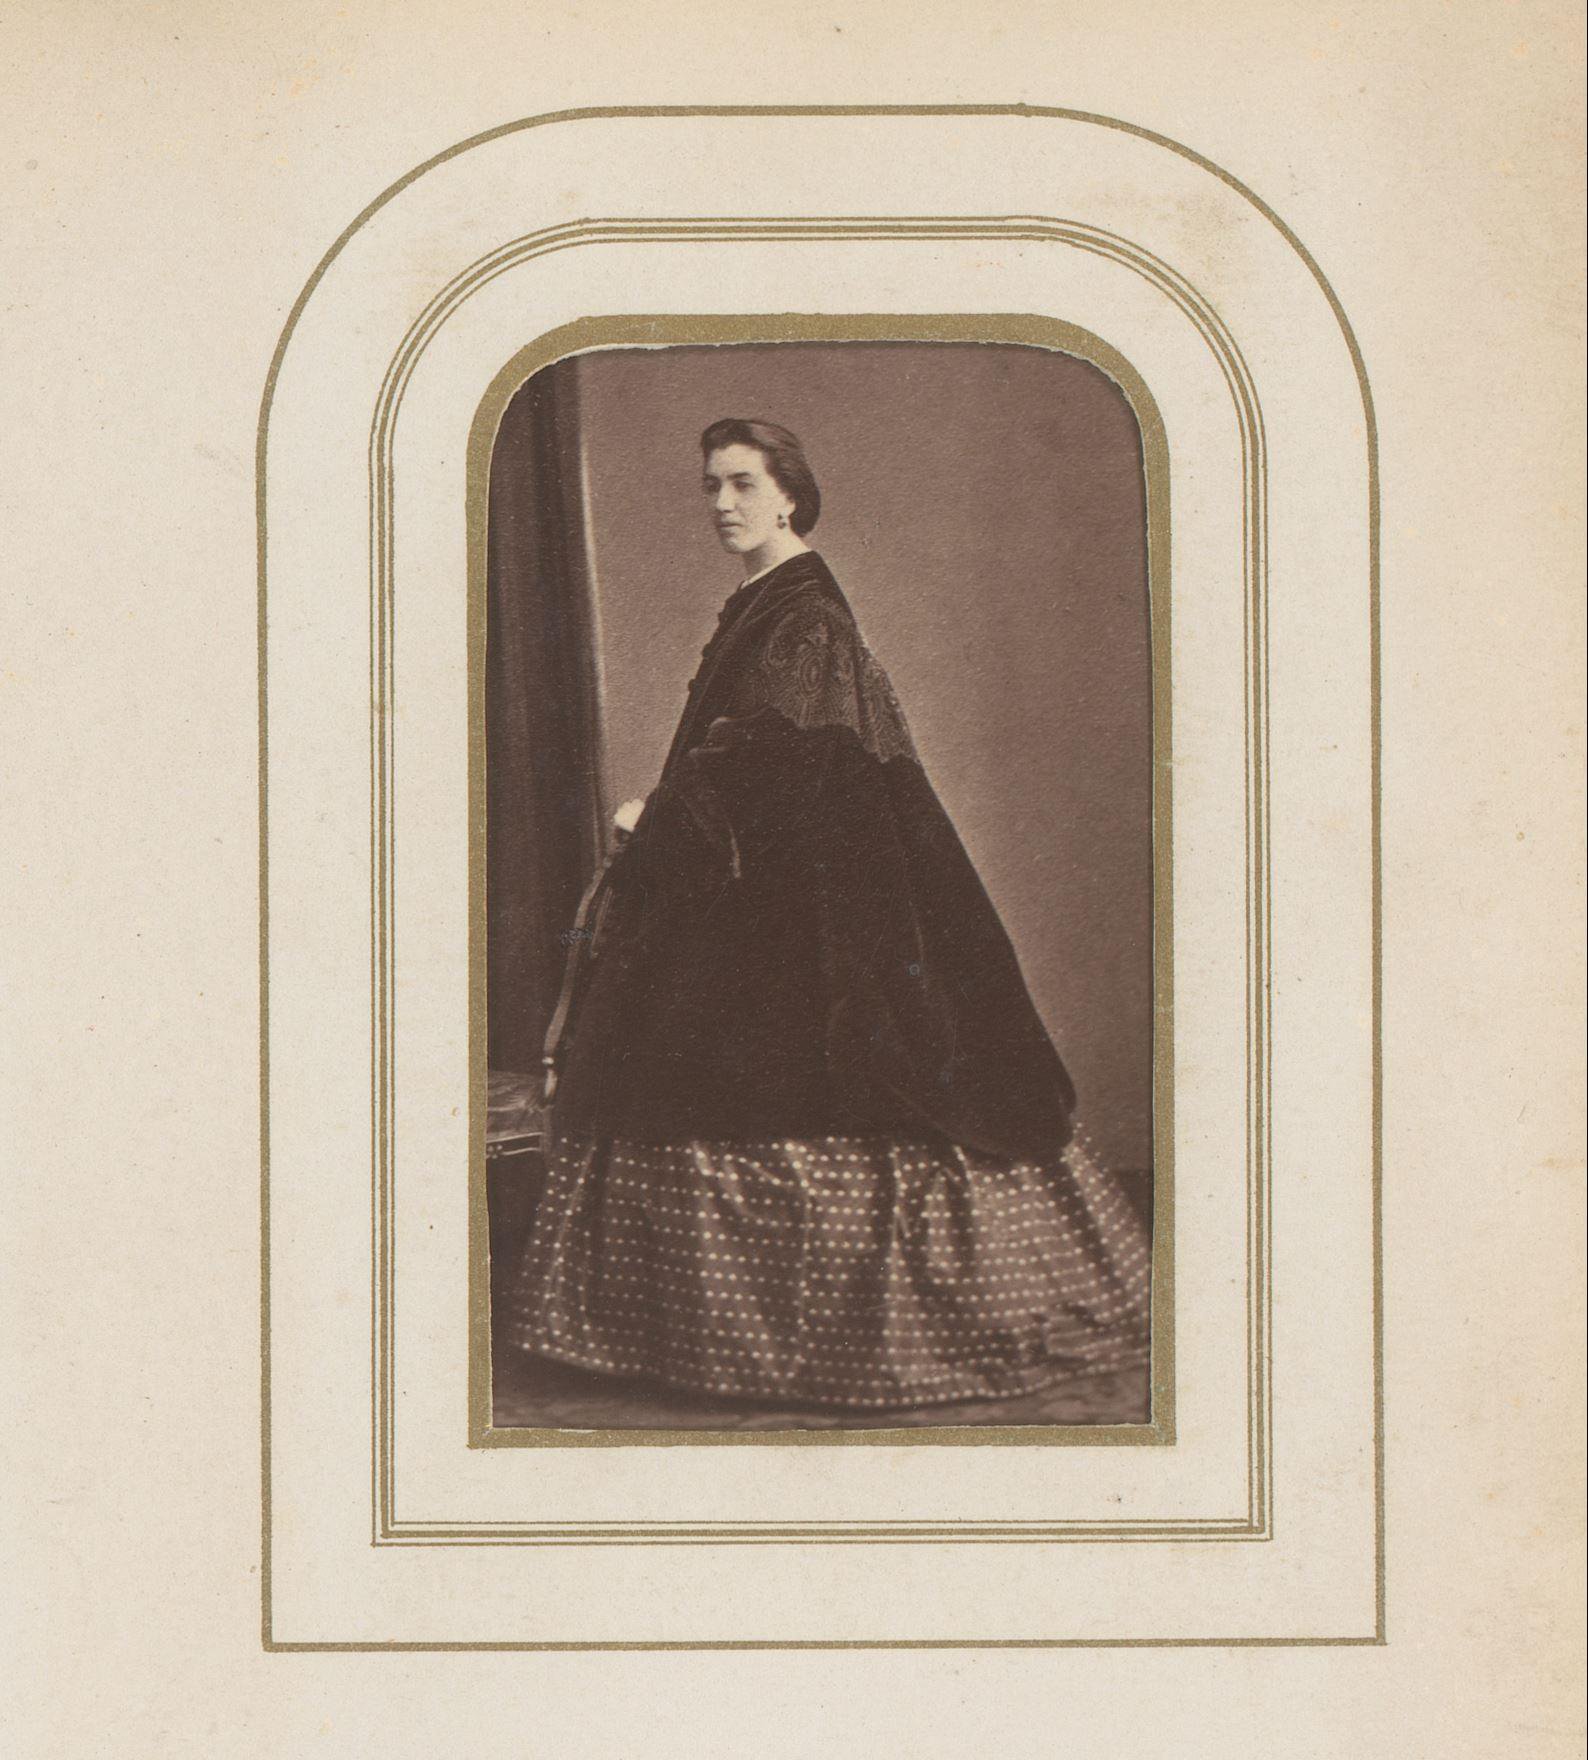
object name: photograph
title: Portret van een staande vrouw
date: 1868-1890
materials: cardboard, photographic support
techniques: albumen print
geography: brussels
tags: historical persons - bb - woman, standing figure - aa - female human figure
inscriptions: number: ‘46776’, inscription: ‘Géruzet Frères/ photographes de la reine/ 27 bis Rue de l'Ecuyer/ Bruxelles’